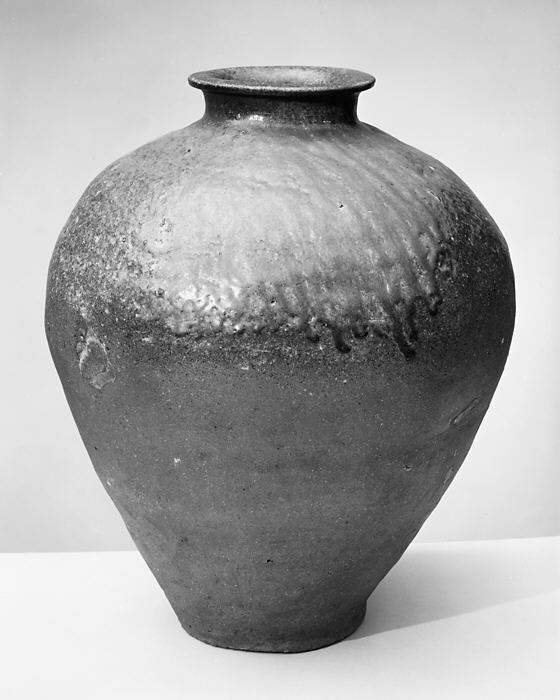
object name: jar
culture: japanese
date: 1301-1500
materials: wood, glaze, stoneware